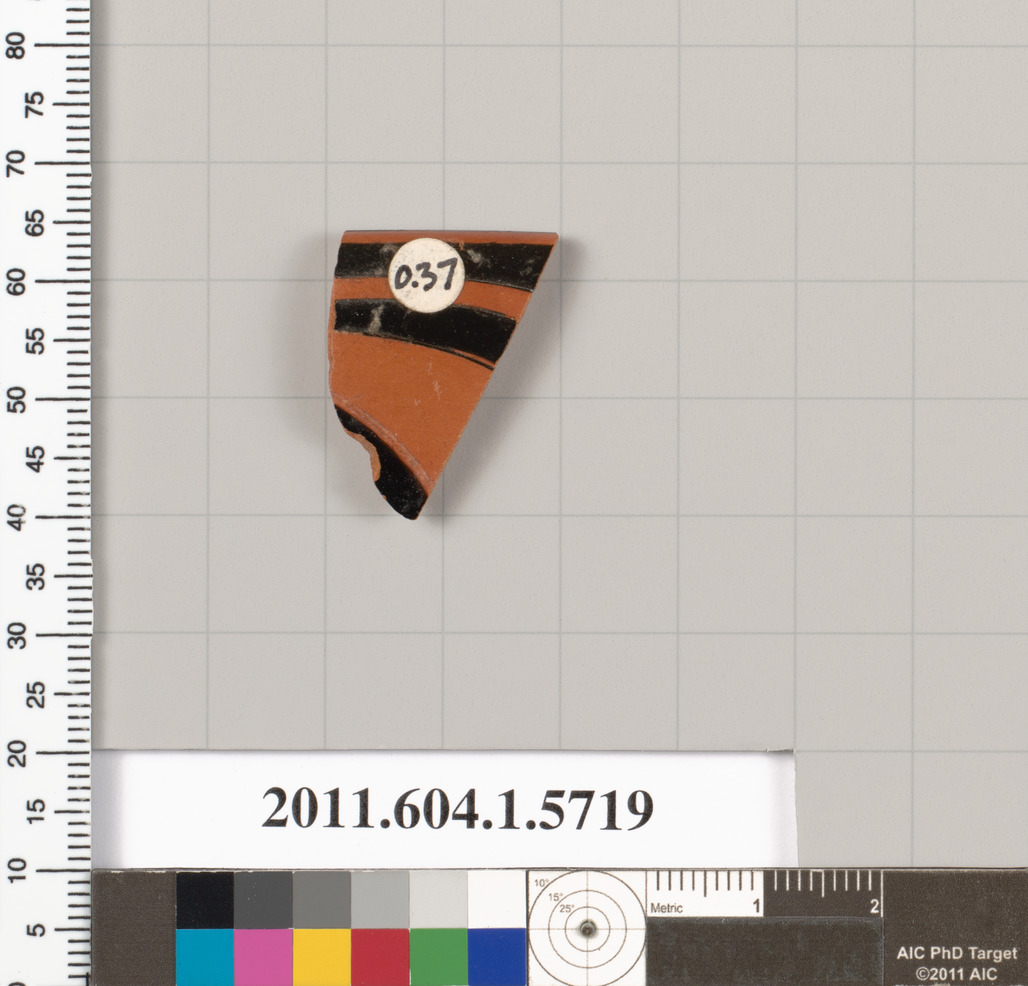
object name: kylix fragment, eye cup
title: Terracotta rim fragment of a kylix: eye-cup (drinking cup)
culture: greek, attic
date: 525-515 BCE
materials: terracotta